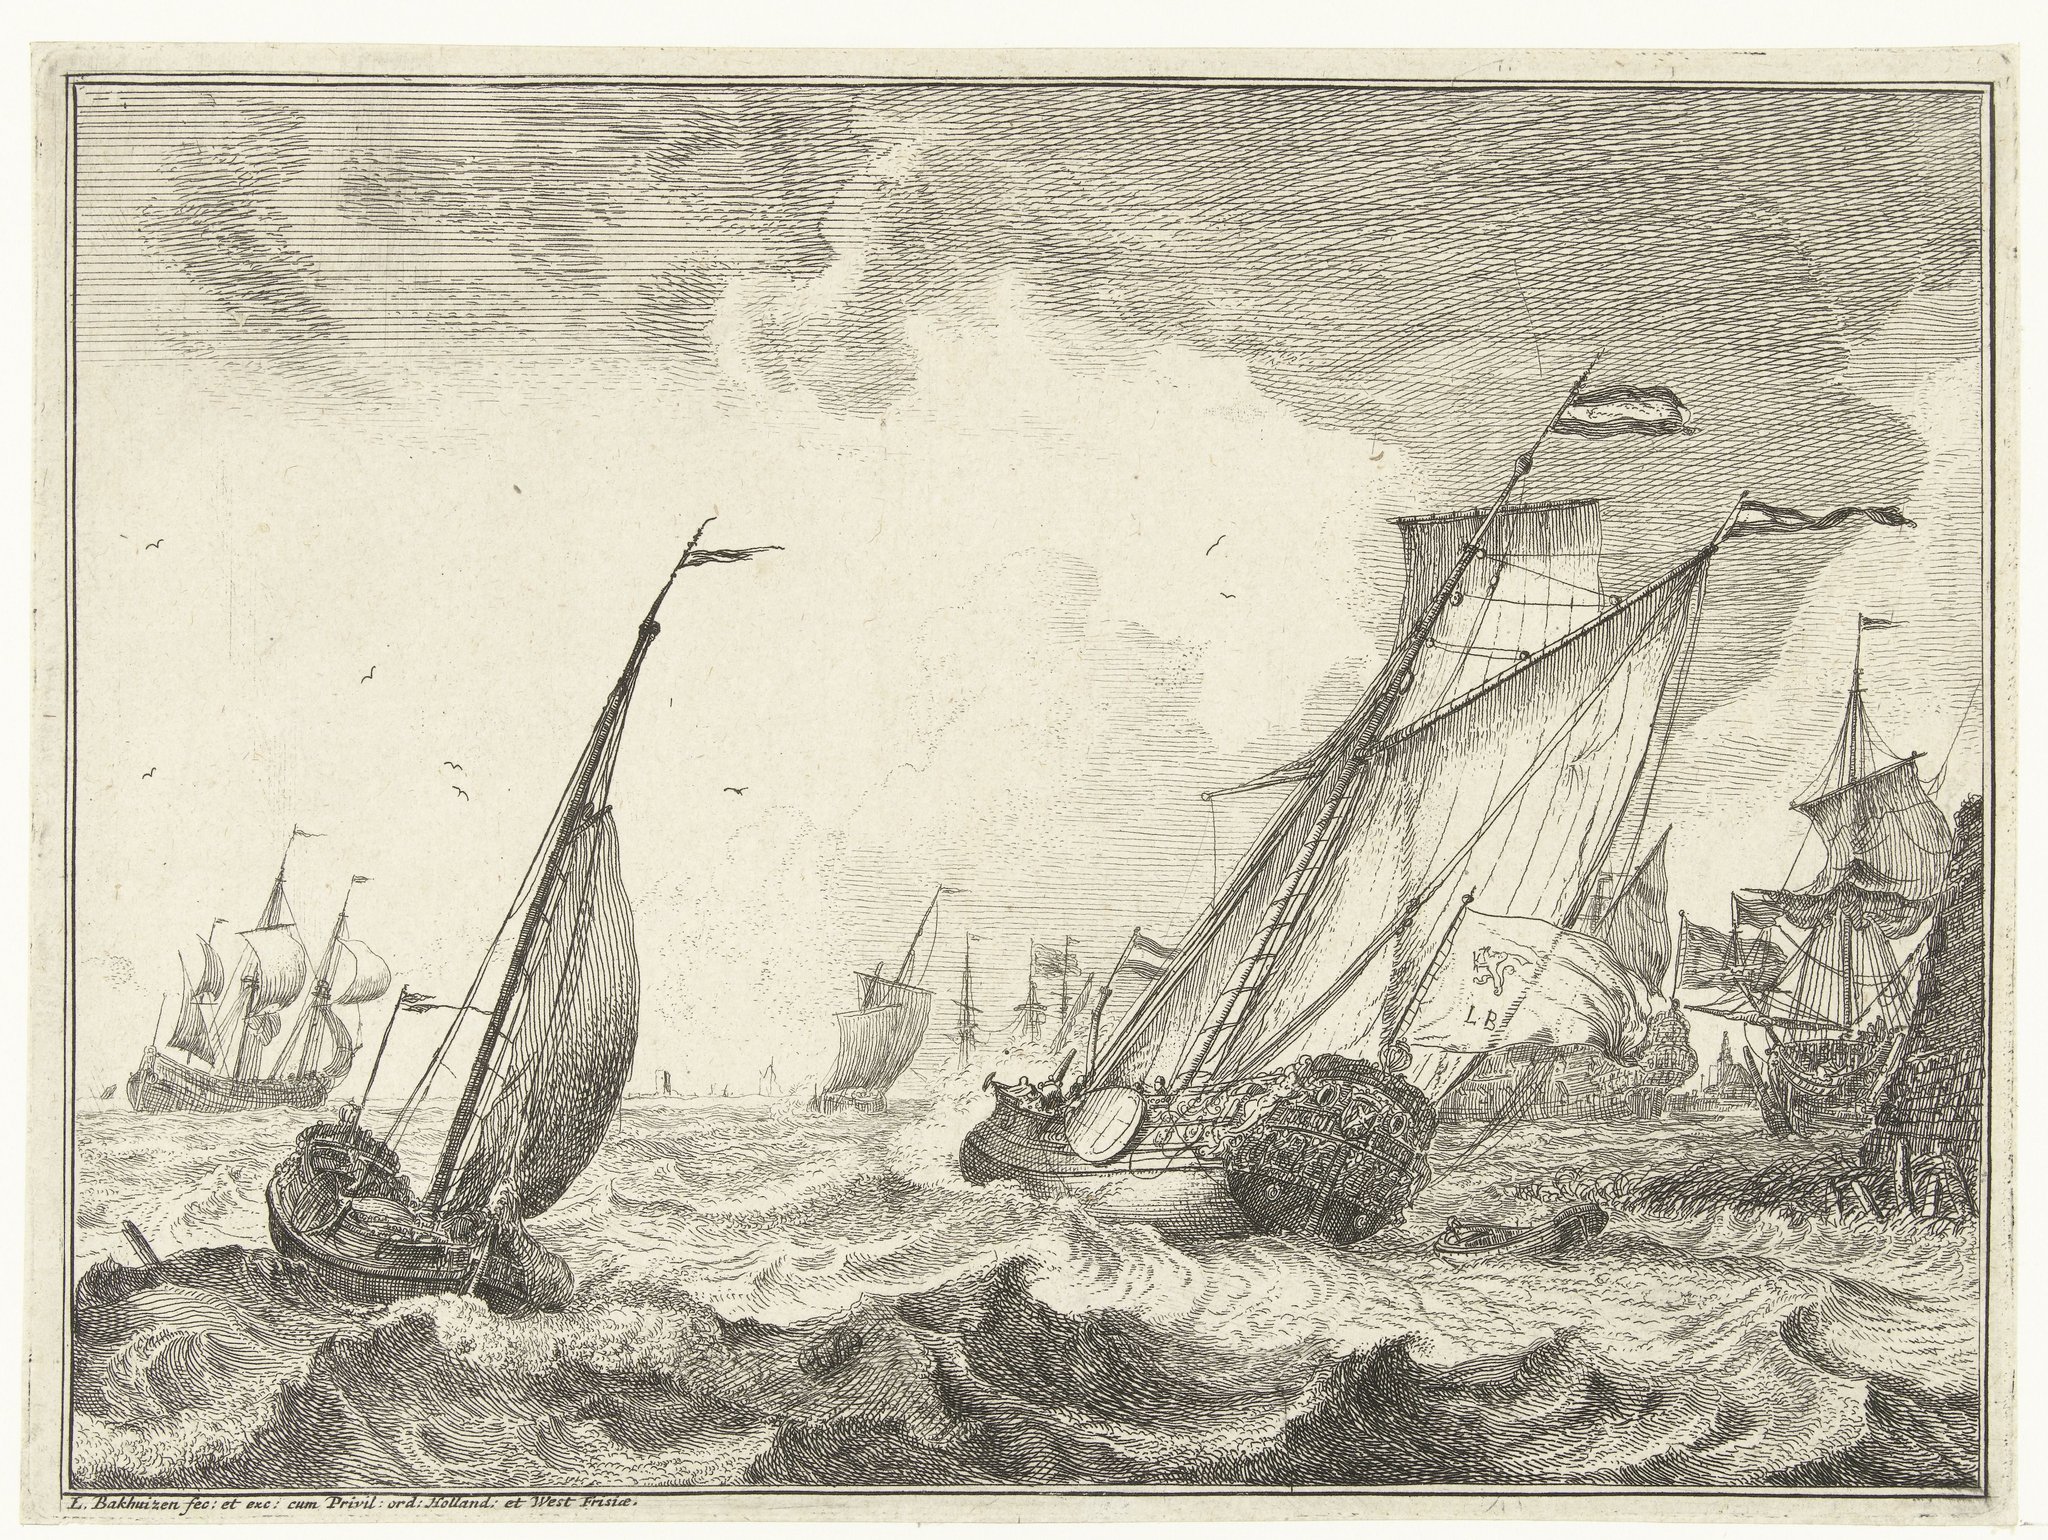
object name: print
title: Schepen op zee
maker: ludolf bakhuysen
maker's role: draughtsman, print maker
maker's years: 1631-1708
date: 1701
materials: paper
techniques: etching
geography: amsterdam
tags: sea (seascape), traffic on the water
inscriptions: collector's mark: Lugt 2228, inscription: ‘F Rechberger 1800’ Lugt 2133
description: Schepen op zee. Prent uit een serie met tien zeegezichten.